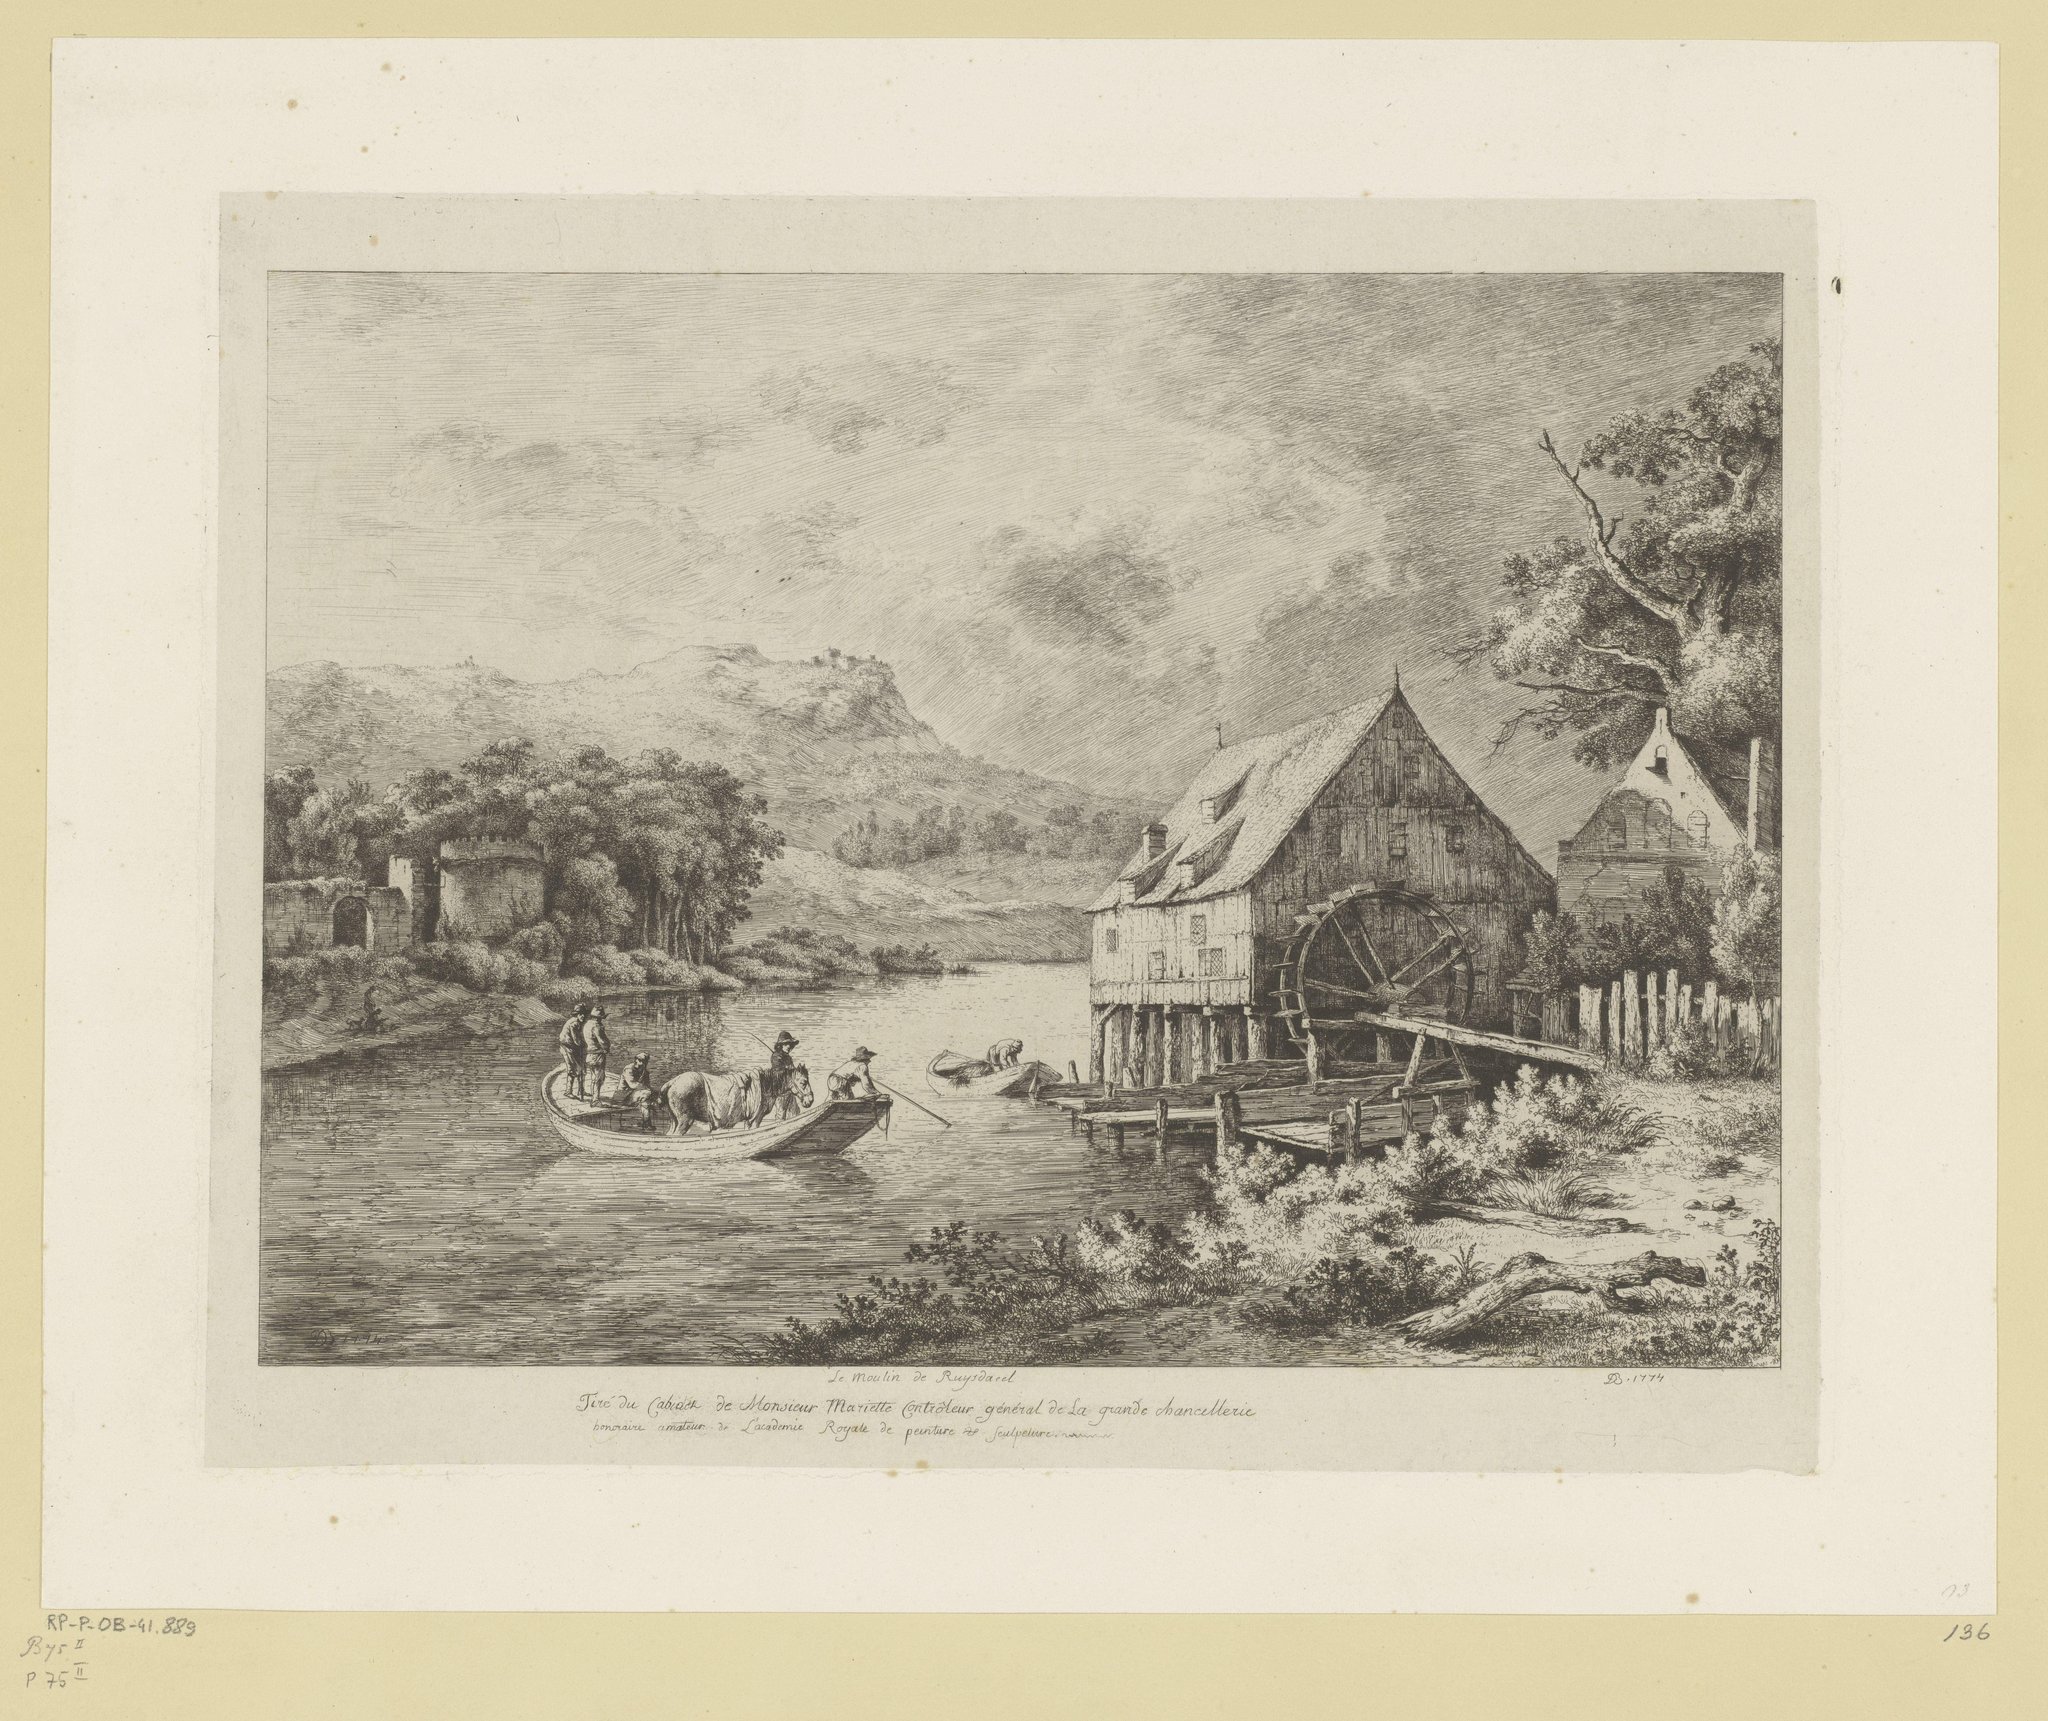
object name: print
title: Le moulin de Ruysdaeel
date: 1774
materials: paper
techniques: drypoint, etching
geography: france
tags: landscapes with waters, waterscapes, seascapes (in the temperate zone), watermill in landscape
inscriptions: collector's mark: Lugt 12